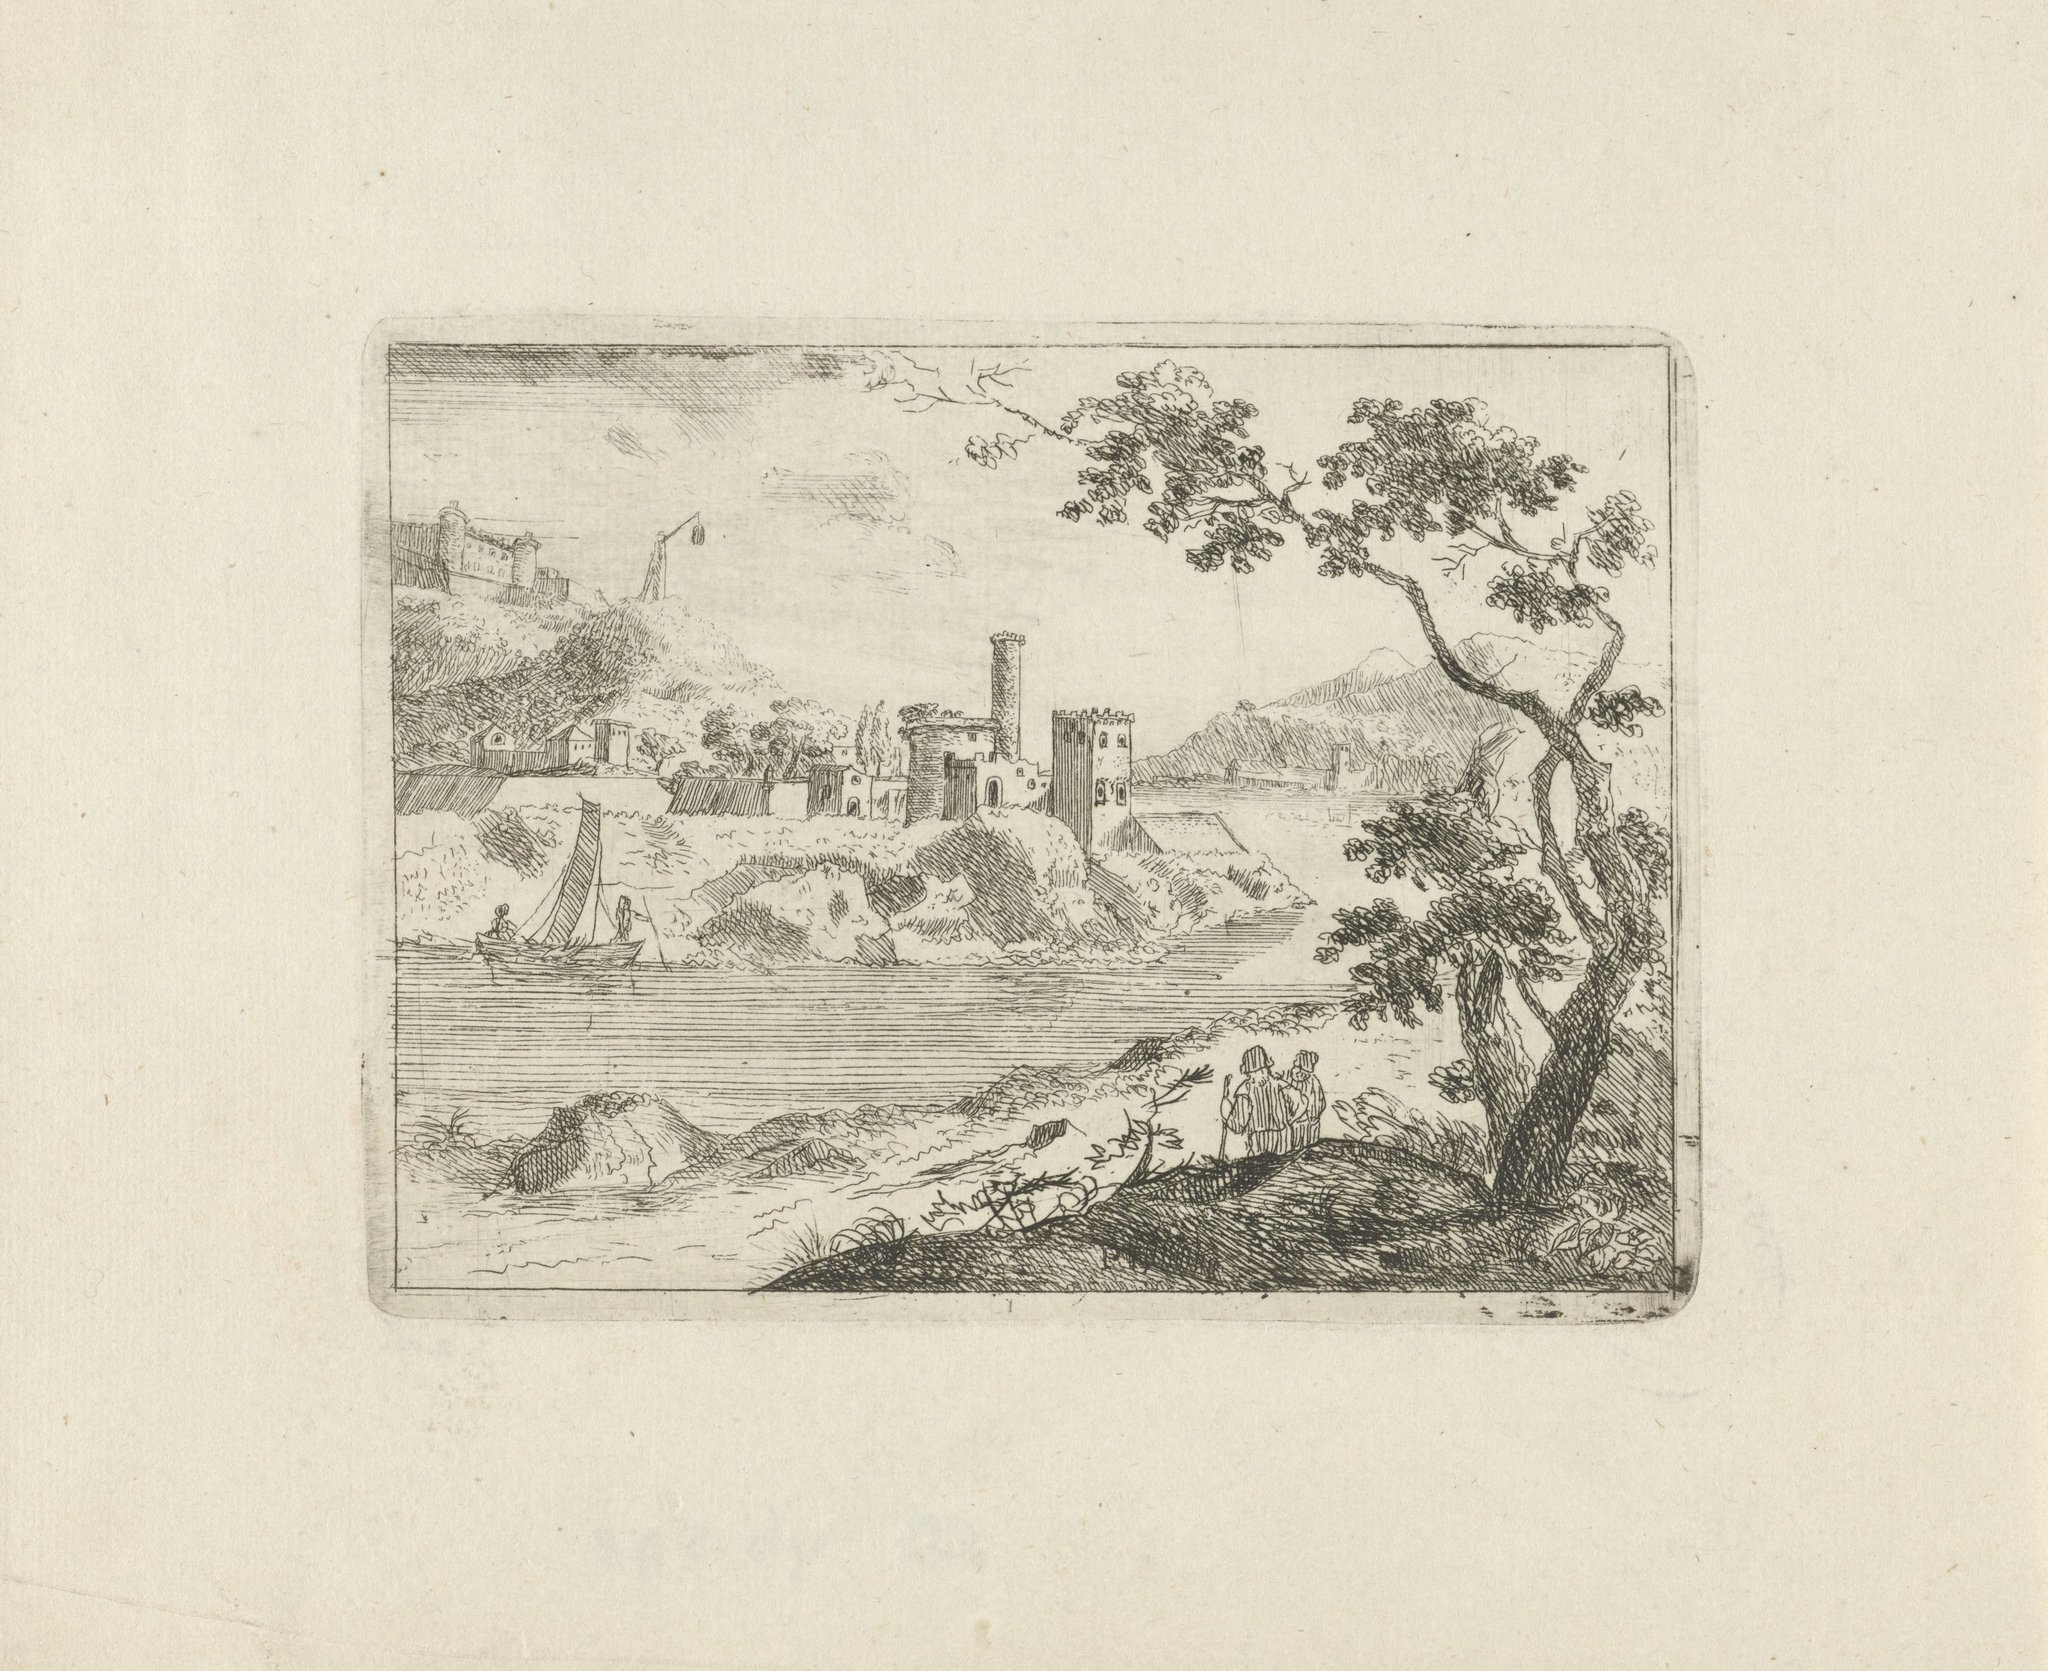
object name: print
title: Riviergezicht met vesting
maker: pieter langendijk (i)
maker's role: print maker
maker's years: 1683-1756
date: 1693-1756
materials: paper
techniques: etching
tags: river - hh - ideal landscapes, fortress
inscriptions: collector's mark: Lugt 240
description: Gezicht op een rivier, aan de overkant ligt op de oever een vesting.